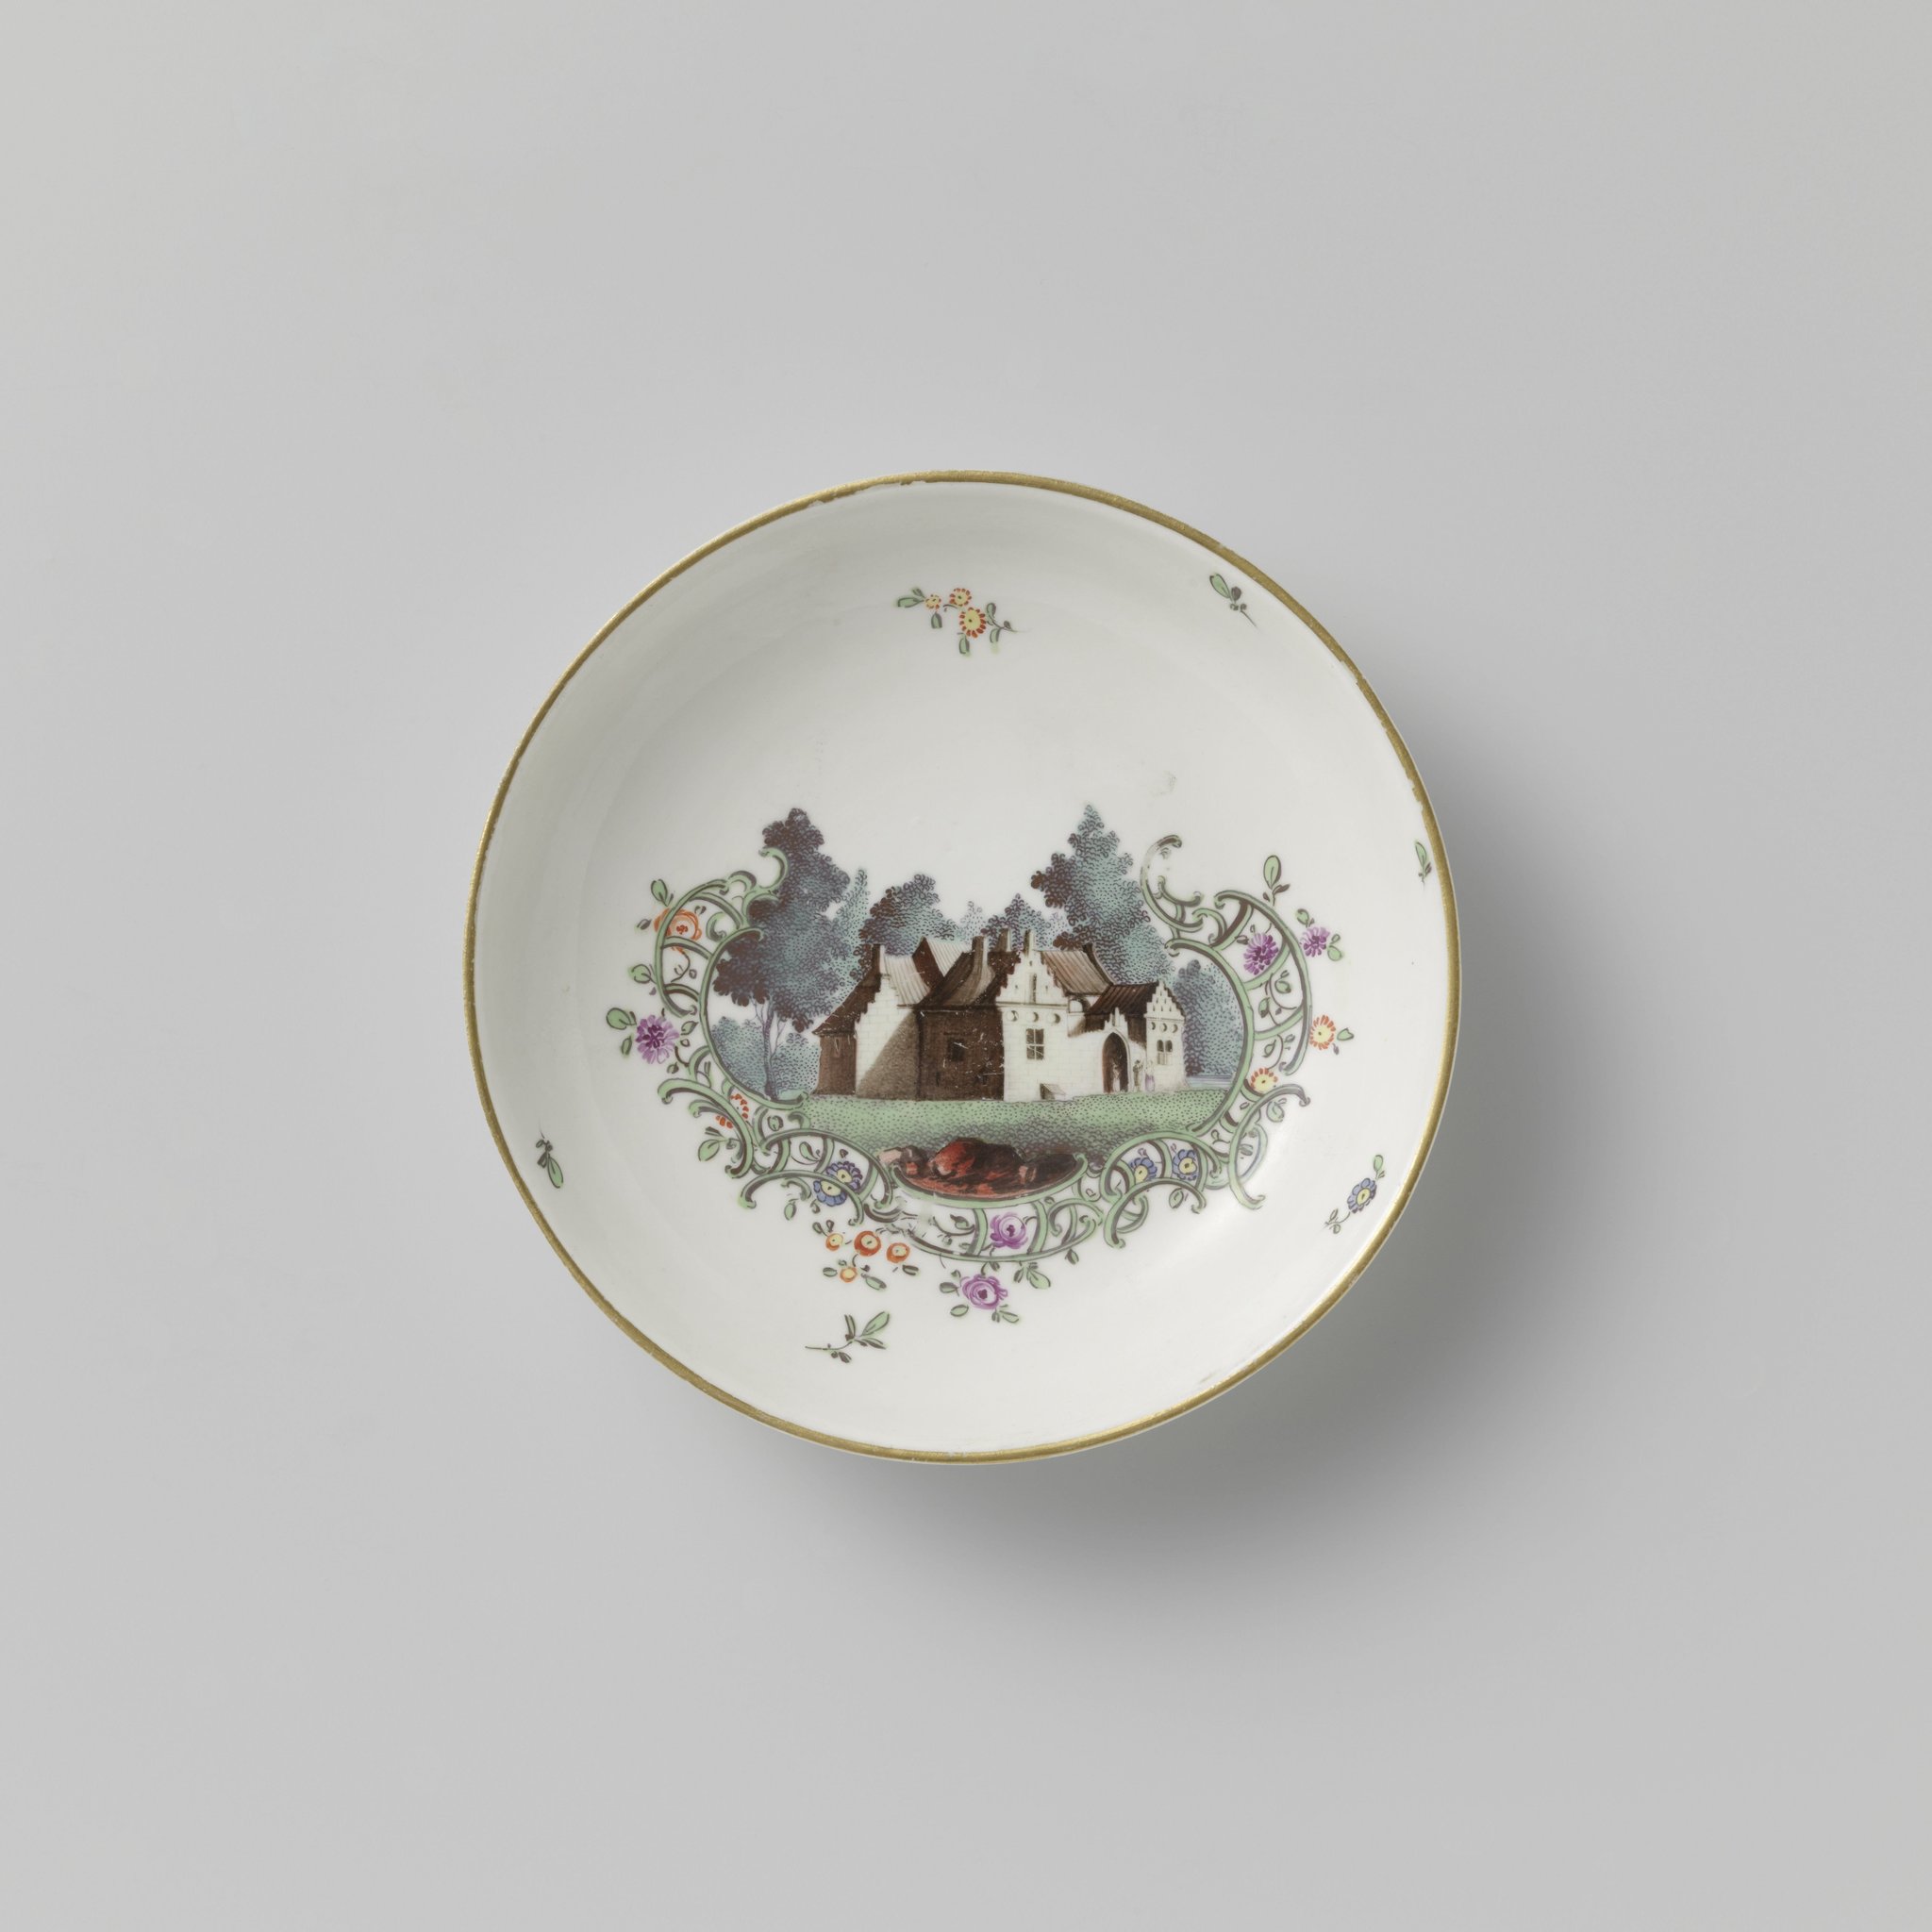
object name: platter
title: Saucer with a castle or estate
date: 1750-1799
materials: glaze, gold, paint, porcelain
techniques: firing, forming, gilding, vitrification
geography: höchst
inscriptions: mark: ‘wiel/ C/ 2M’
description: Schotel van porselein, beschilderd op het glazuur in emailkleuren en goud. Op het plat een kasteel of landhuis in een bos, omgeven door bloemranken. Strooibloemen op de wand. Gouden rand. Gemerkt op de onderzijde met het wiel, C en 2M.